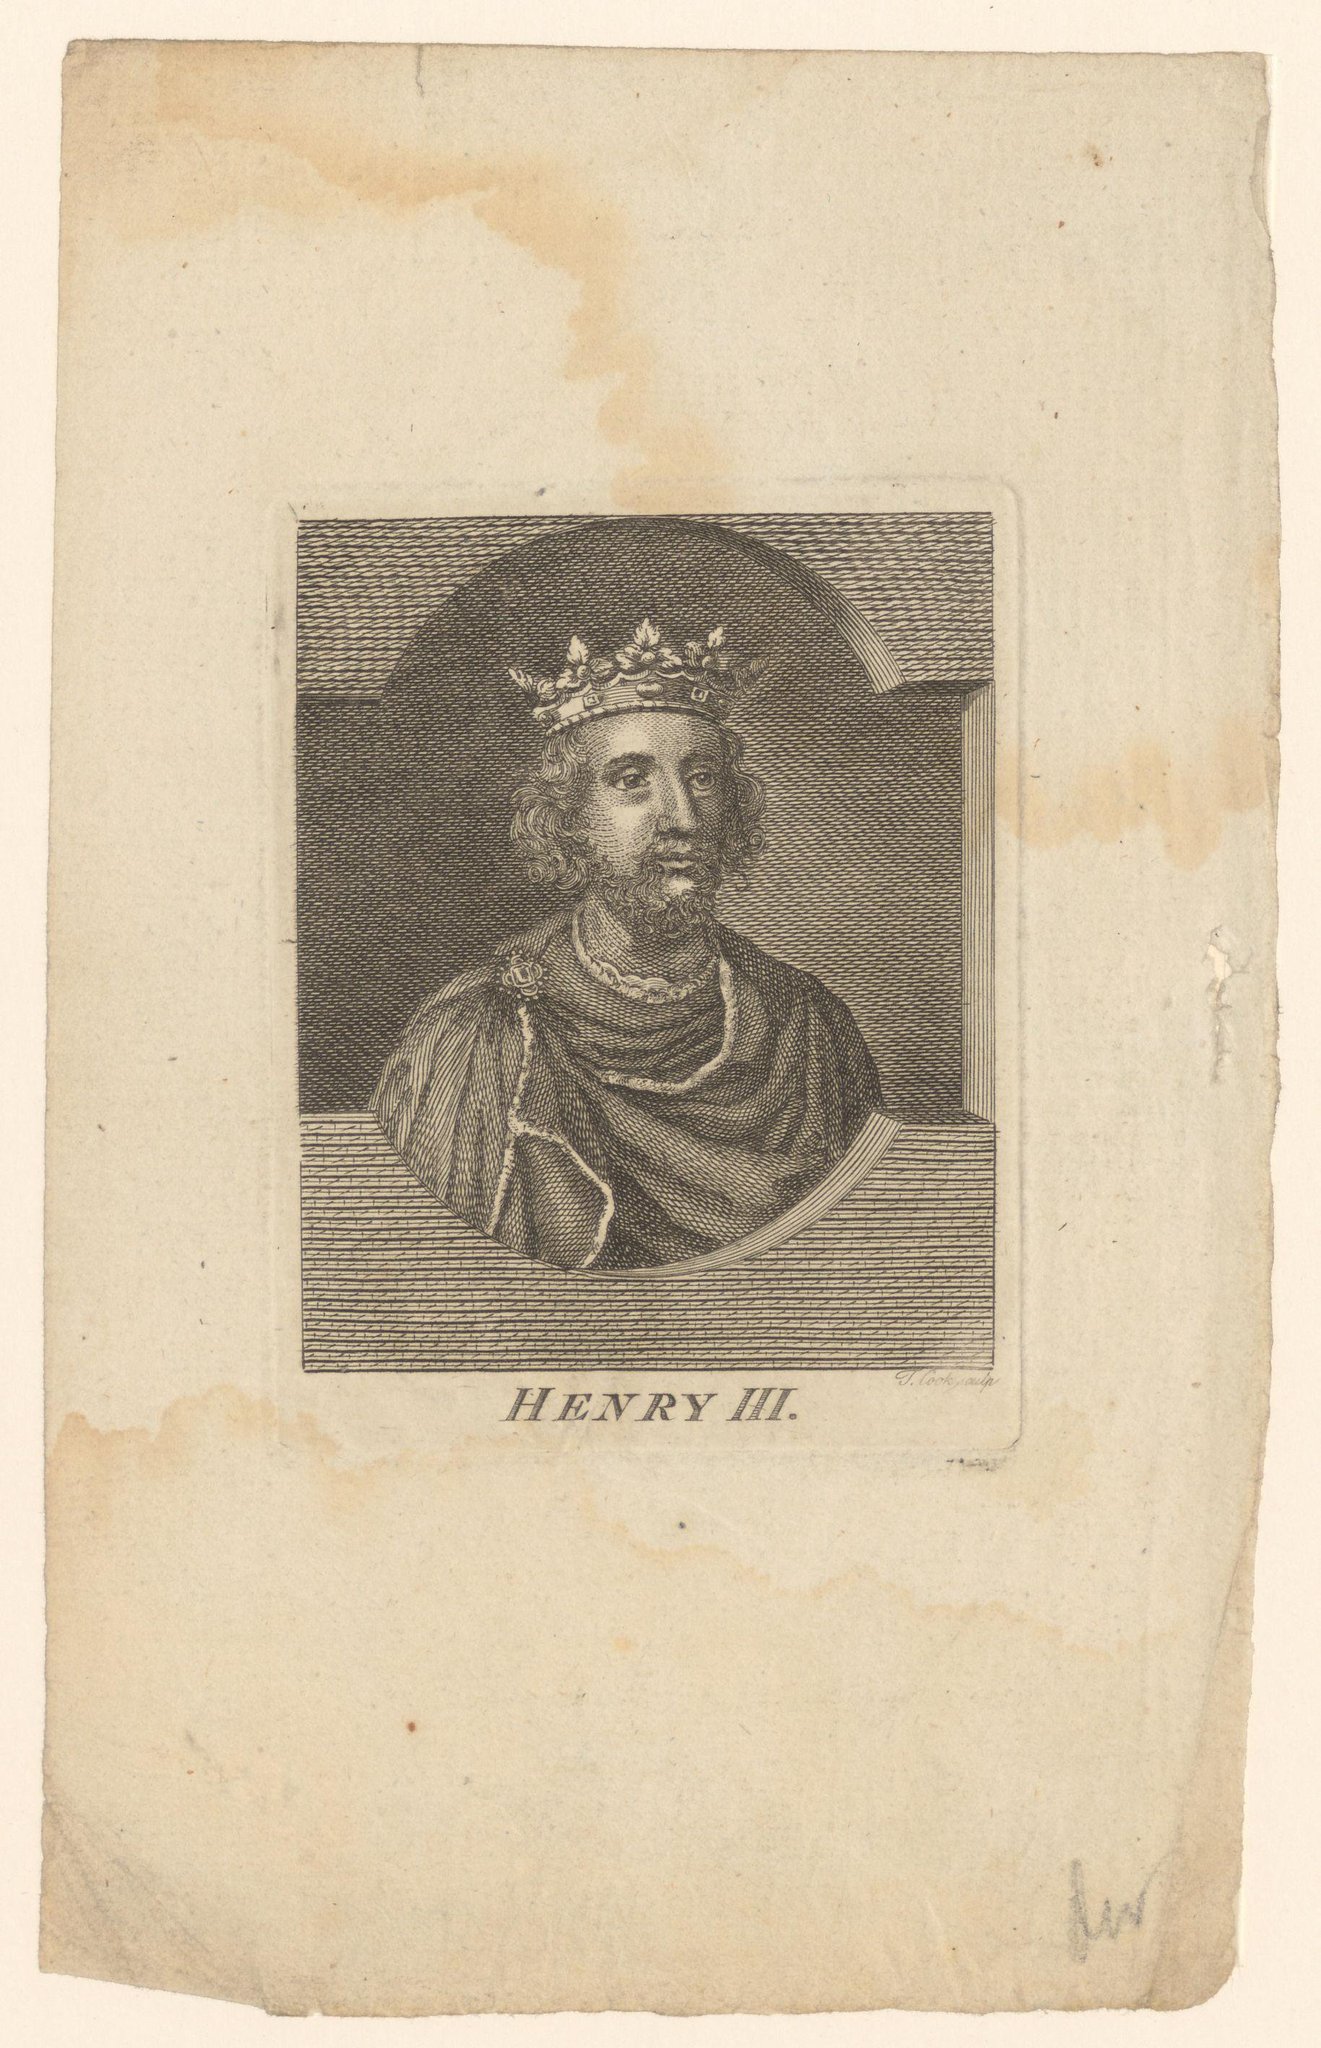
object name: print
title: Portret van Henry III, koning van Groot-Brittannië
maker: thomas cook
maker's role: print maker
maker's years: 1744-1818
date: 1754-1818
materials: paper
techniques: etching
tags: historical persons, king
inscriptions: collector's mark: Lugt 2228